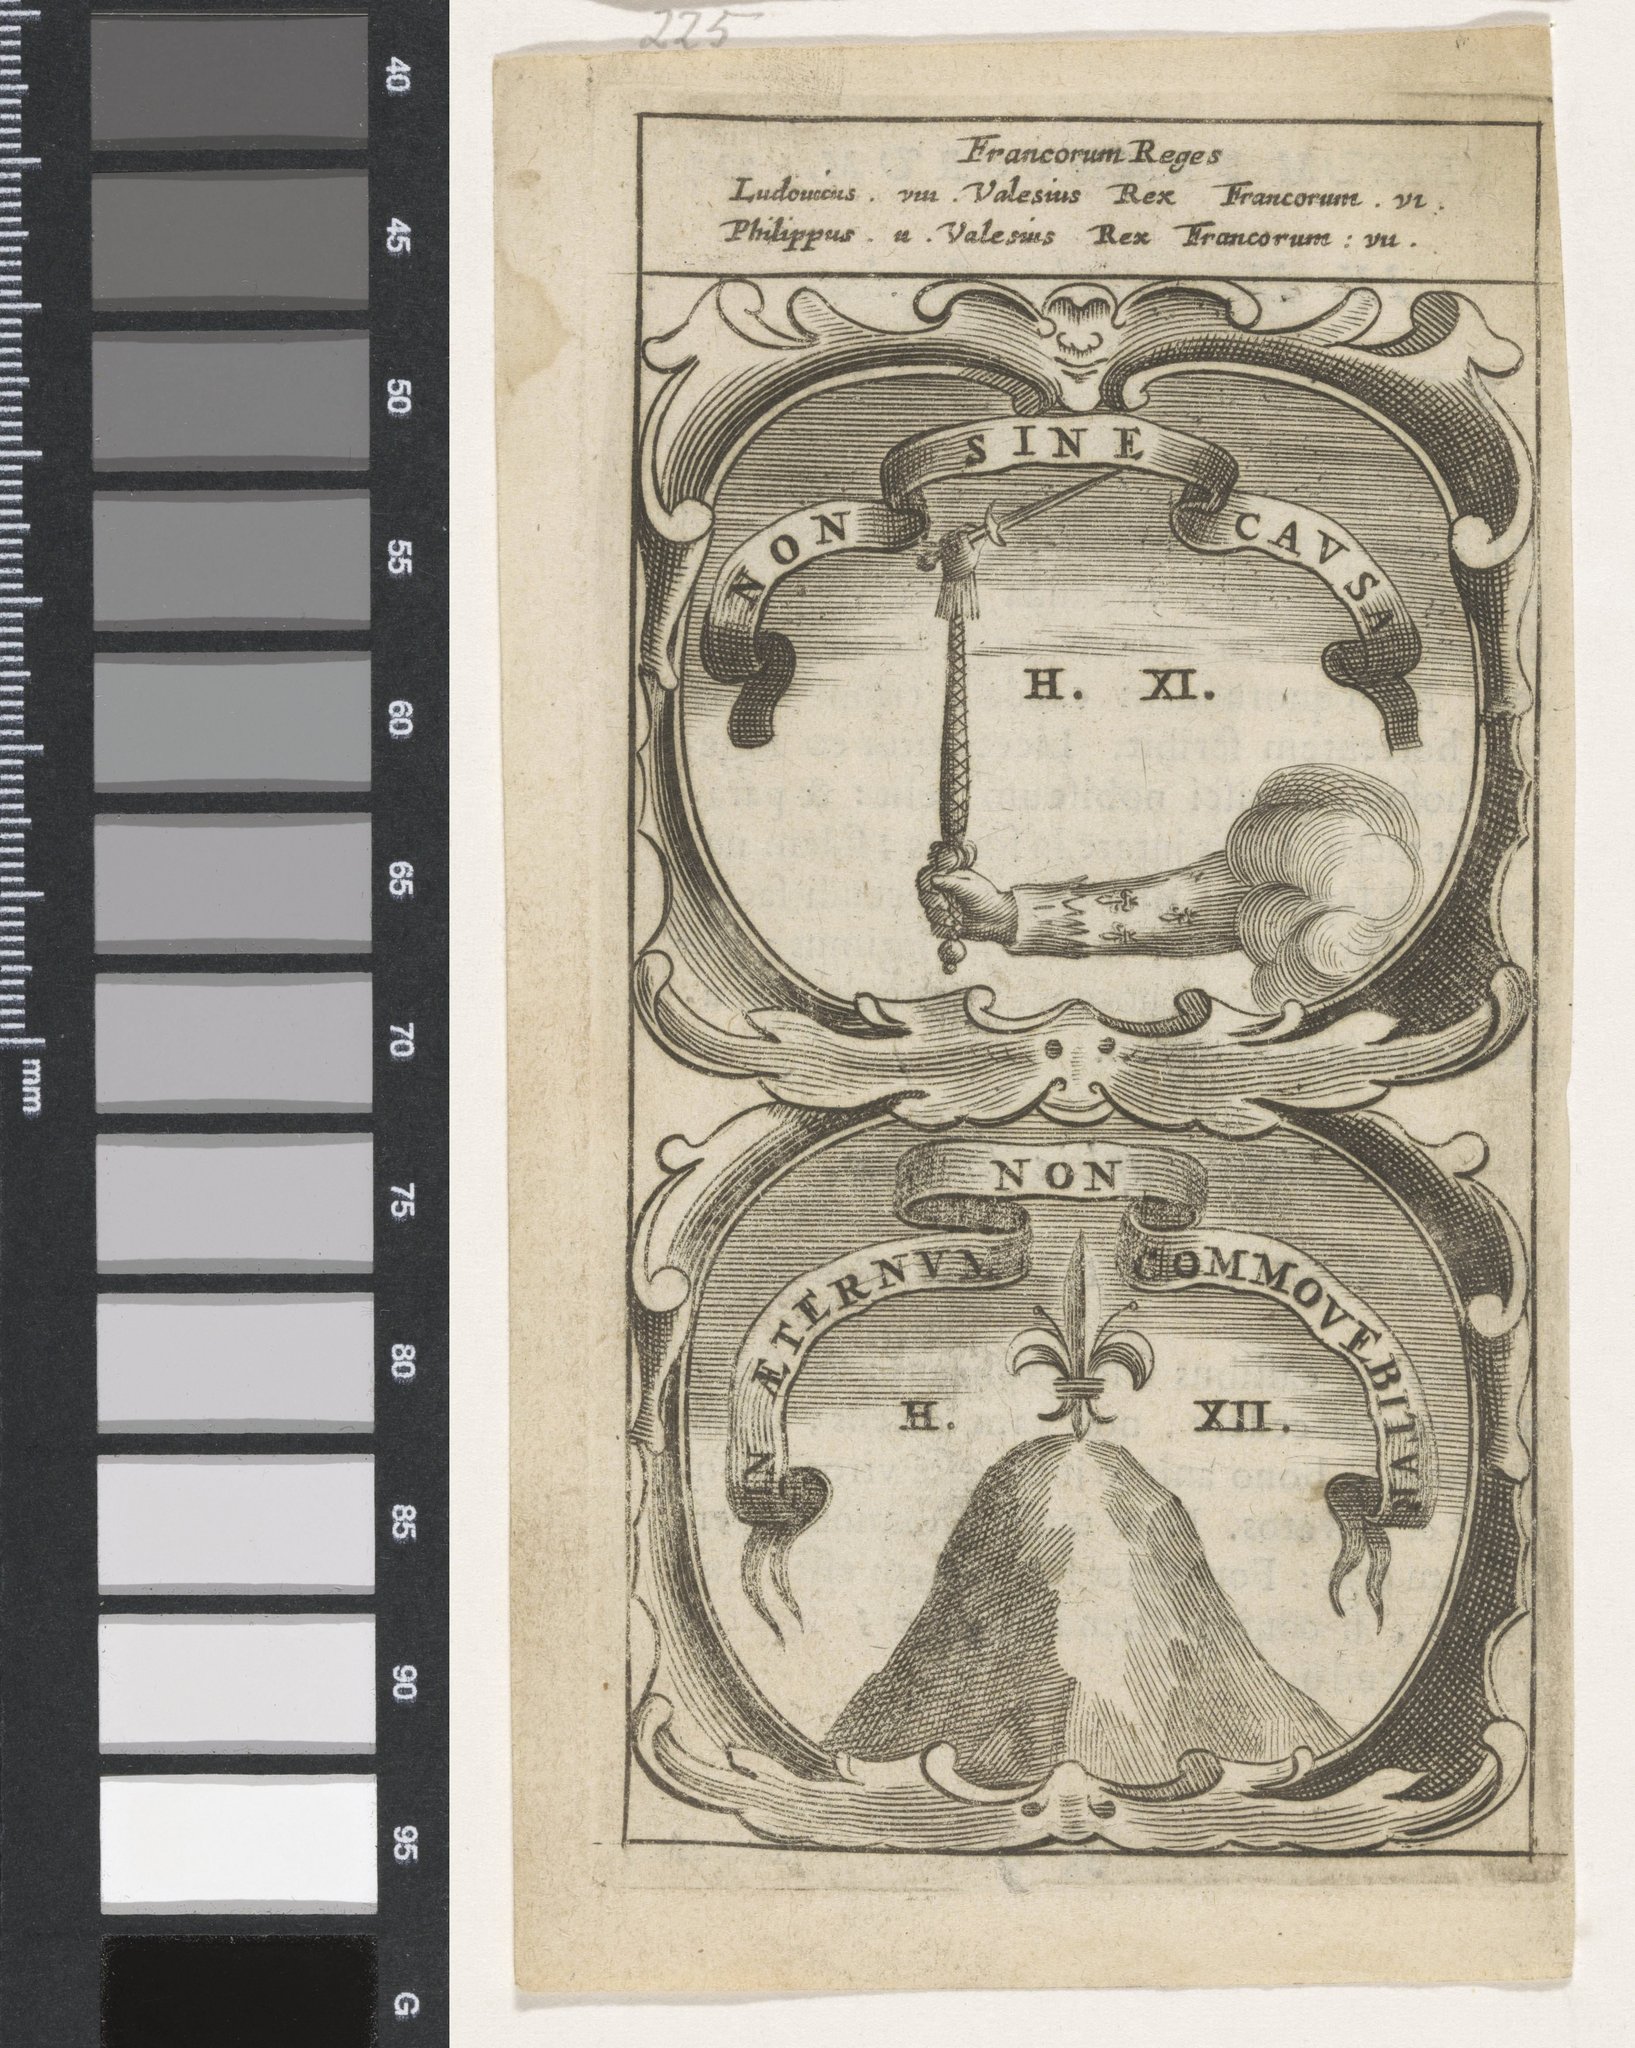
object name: print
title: Koninklijke arm met scepter en zwaard / Franse lelie op een berg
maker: Anonymous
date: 1666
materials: paper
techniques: engraving, letterpress printing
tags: paris, scorpions, postures and gestures of arms and hands, mountains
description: Een embleem met twee voorstellingen. Boven een arm gekleed in mouw met Franse lelie. De koninklijke arm heeft een scepter vast. De scepter heeft een zwaard. Onder een berg waarop een Franse lelie. Het betreffen deviezen van koning Lodewijk II en Filips II van Frankrijk.